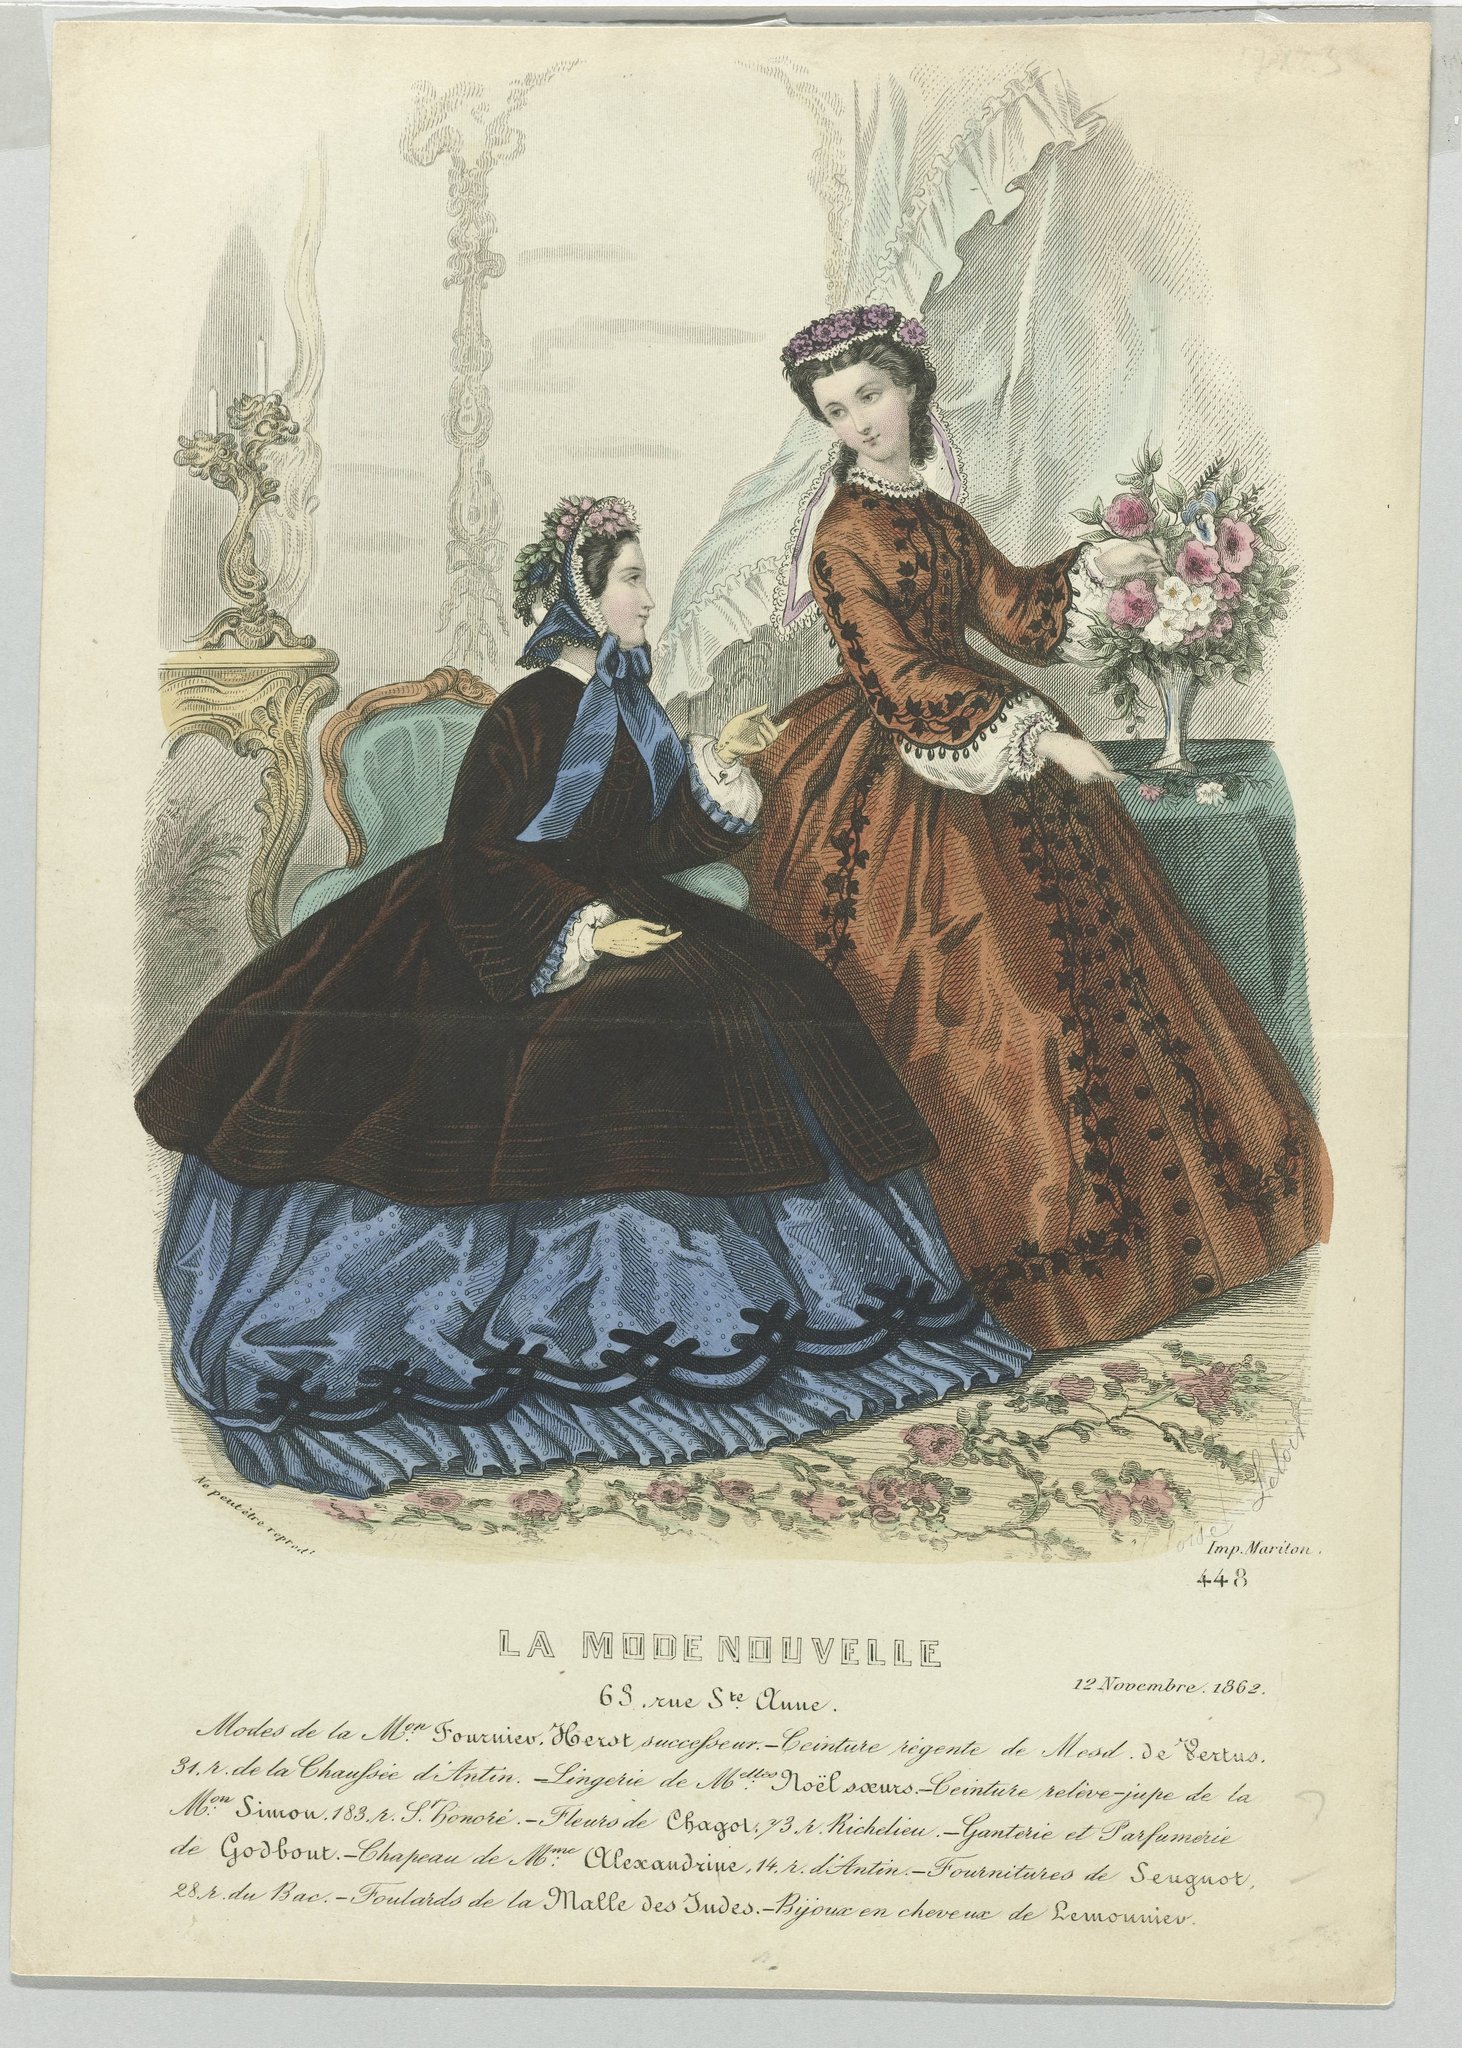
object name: fashion print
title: La Mode Nouvelle, 12 novembre 1862, No. 448: Modes de la M.on Fournier (...)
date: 1862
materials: paper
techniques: engraving, hand coloring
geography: paris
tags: arranging flowers, coat (+ women's clothes), fashion plates, head-gear: hat (+ women's clothes), skirt (+ women's clothes), gloves, mittens, etc. (+ women's clothes)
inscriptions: caption: ‘Modes de la M.on Fournier, Herst successeur. - Ceinture régente de Mesd. de Vertus. 31.r. de la Chaussée d'Antin. - Lingerie de M.elles Noël soeurs.- Ceinture relève-jupe de la M.on Simon.183.r. S.t Honoré.- Fleurs de Chagot, 73.r. Richelieu. - Ganterie et Parfumerie de Godbout. - Chapeau de M.me Alexandrine,14.r. d'Antin. - Fournitures de Seuguot, 28,r. du Bac. - Foulards de la Malle des Indes. - Bijoux en cheveux de Lemonnier.’, title: ‘La Mode Nouvelle’, address: ‘63, rue S.te Anne.’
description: Twee vrouwen in een interieur, van wie één een boeket bloemen aan het schikken is. Onder de voorstelling enkele regels reclametekst voor verschillende producten. Prent uit het modetijdschrift La Mode Nouvelle (1856-1862).